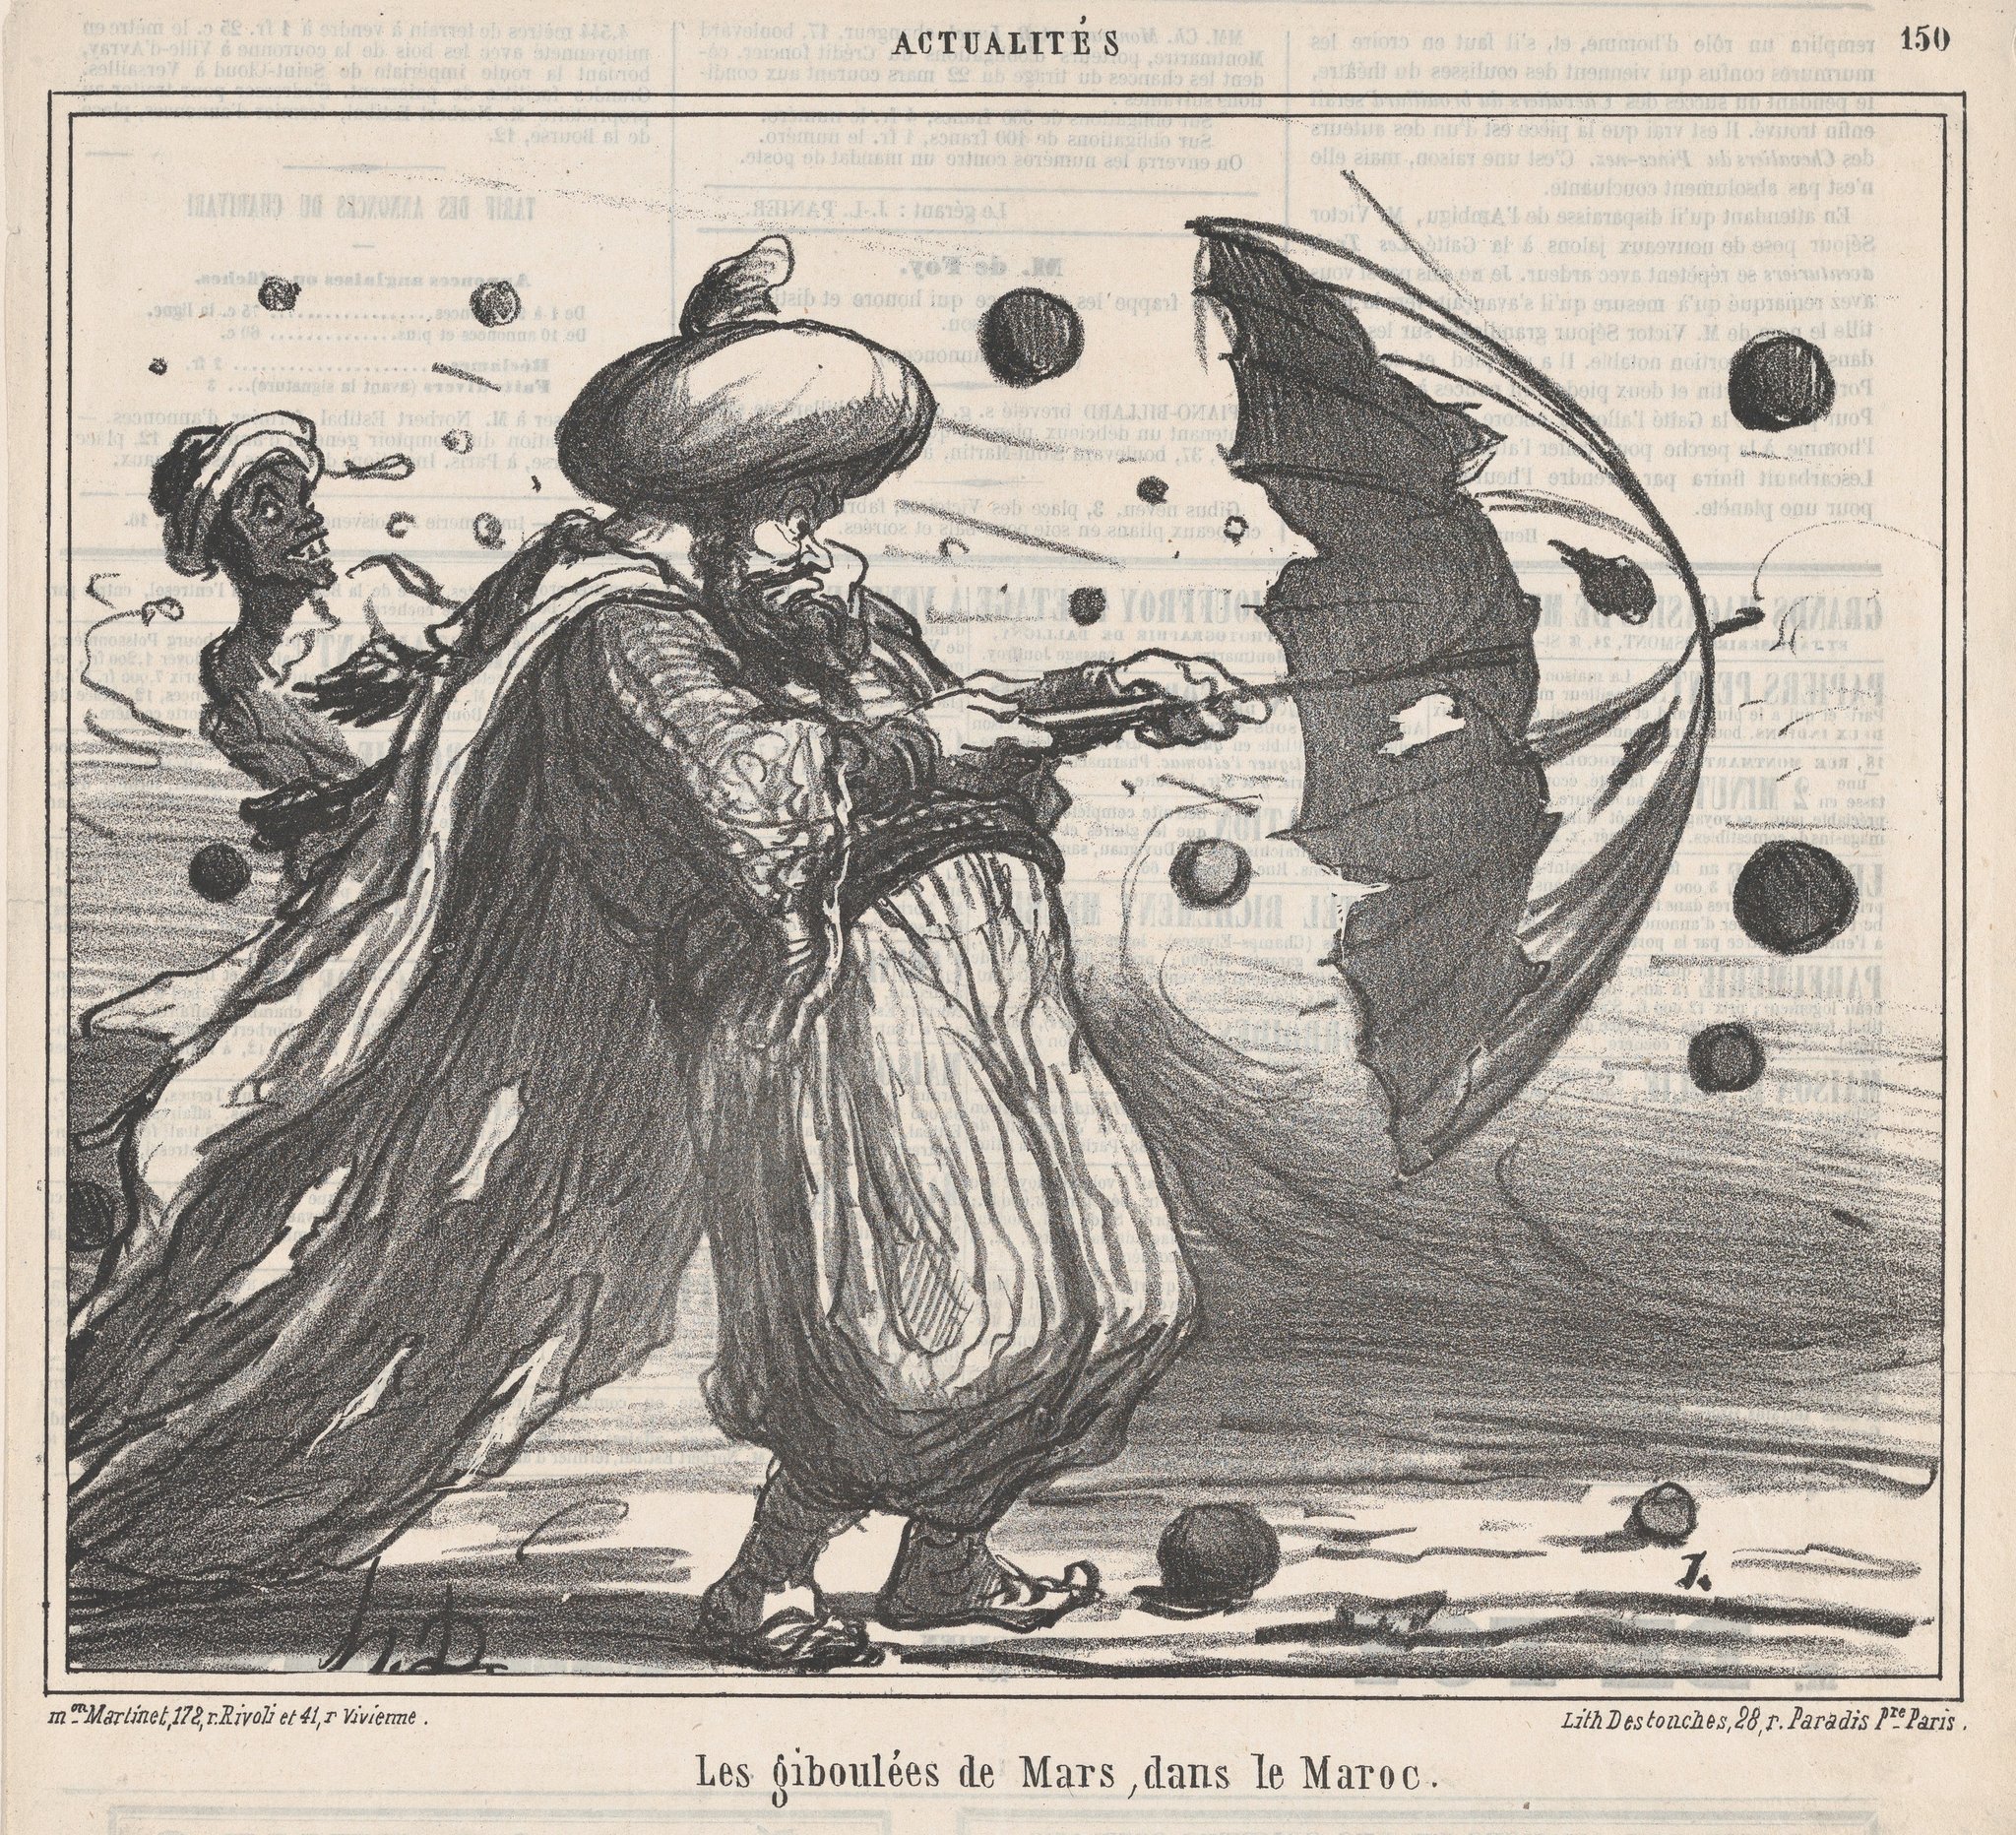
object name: print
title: Sudden showers in March, in Morocco, from "News of the Day"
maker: honoré daumier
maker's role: artist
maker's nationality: french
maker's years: 1808-1879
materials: paper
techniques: lithograph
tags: satire,men,umbrellas